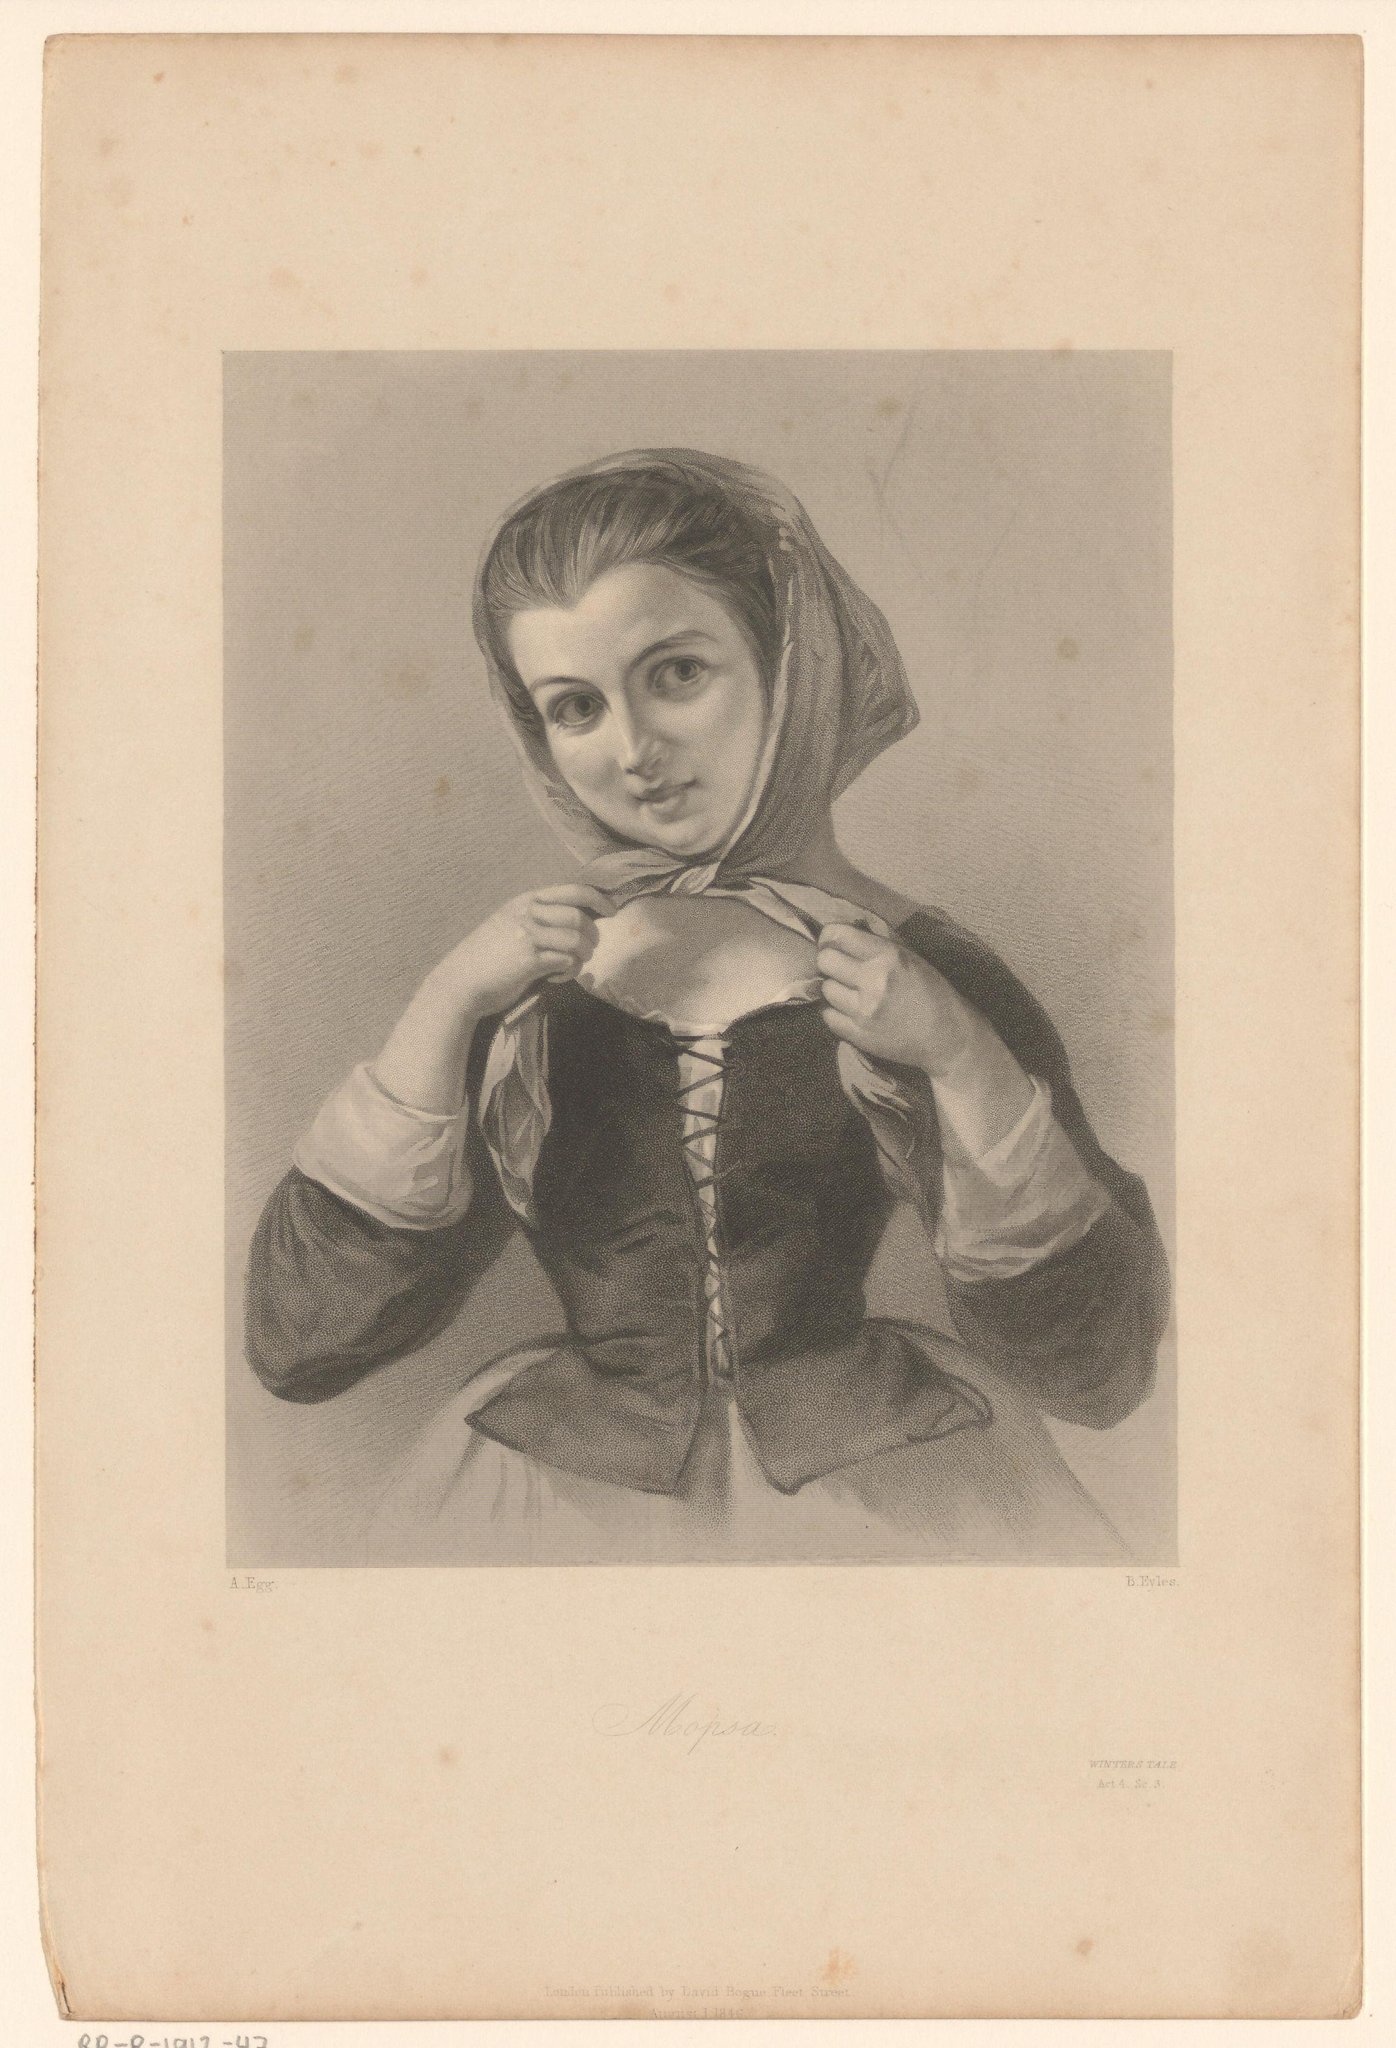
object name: book illustration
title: Mopsa, uit Shakespeare's Wintersprookje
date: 1808-1846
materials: paper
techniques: etching, roulette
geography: london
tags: william shakespeare, female literary characters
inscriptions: collector's mark: Lugt 2228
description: Prent ook gebruikt in: Heath, Charles. The heroines of Shakespeare: comprising the principal female characters in the plays of the great poet. Londen: David Bogue, 1848.